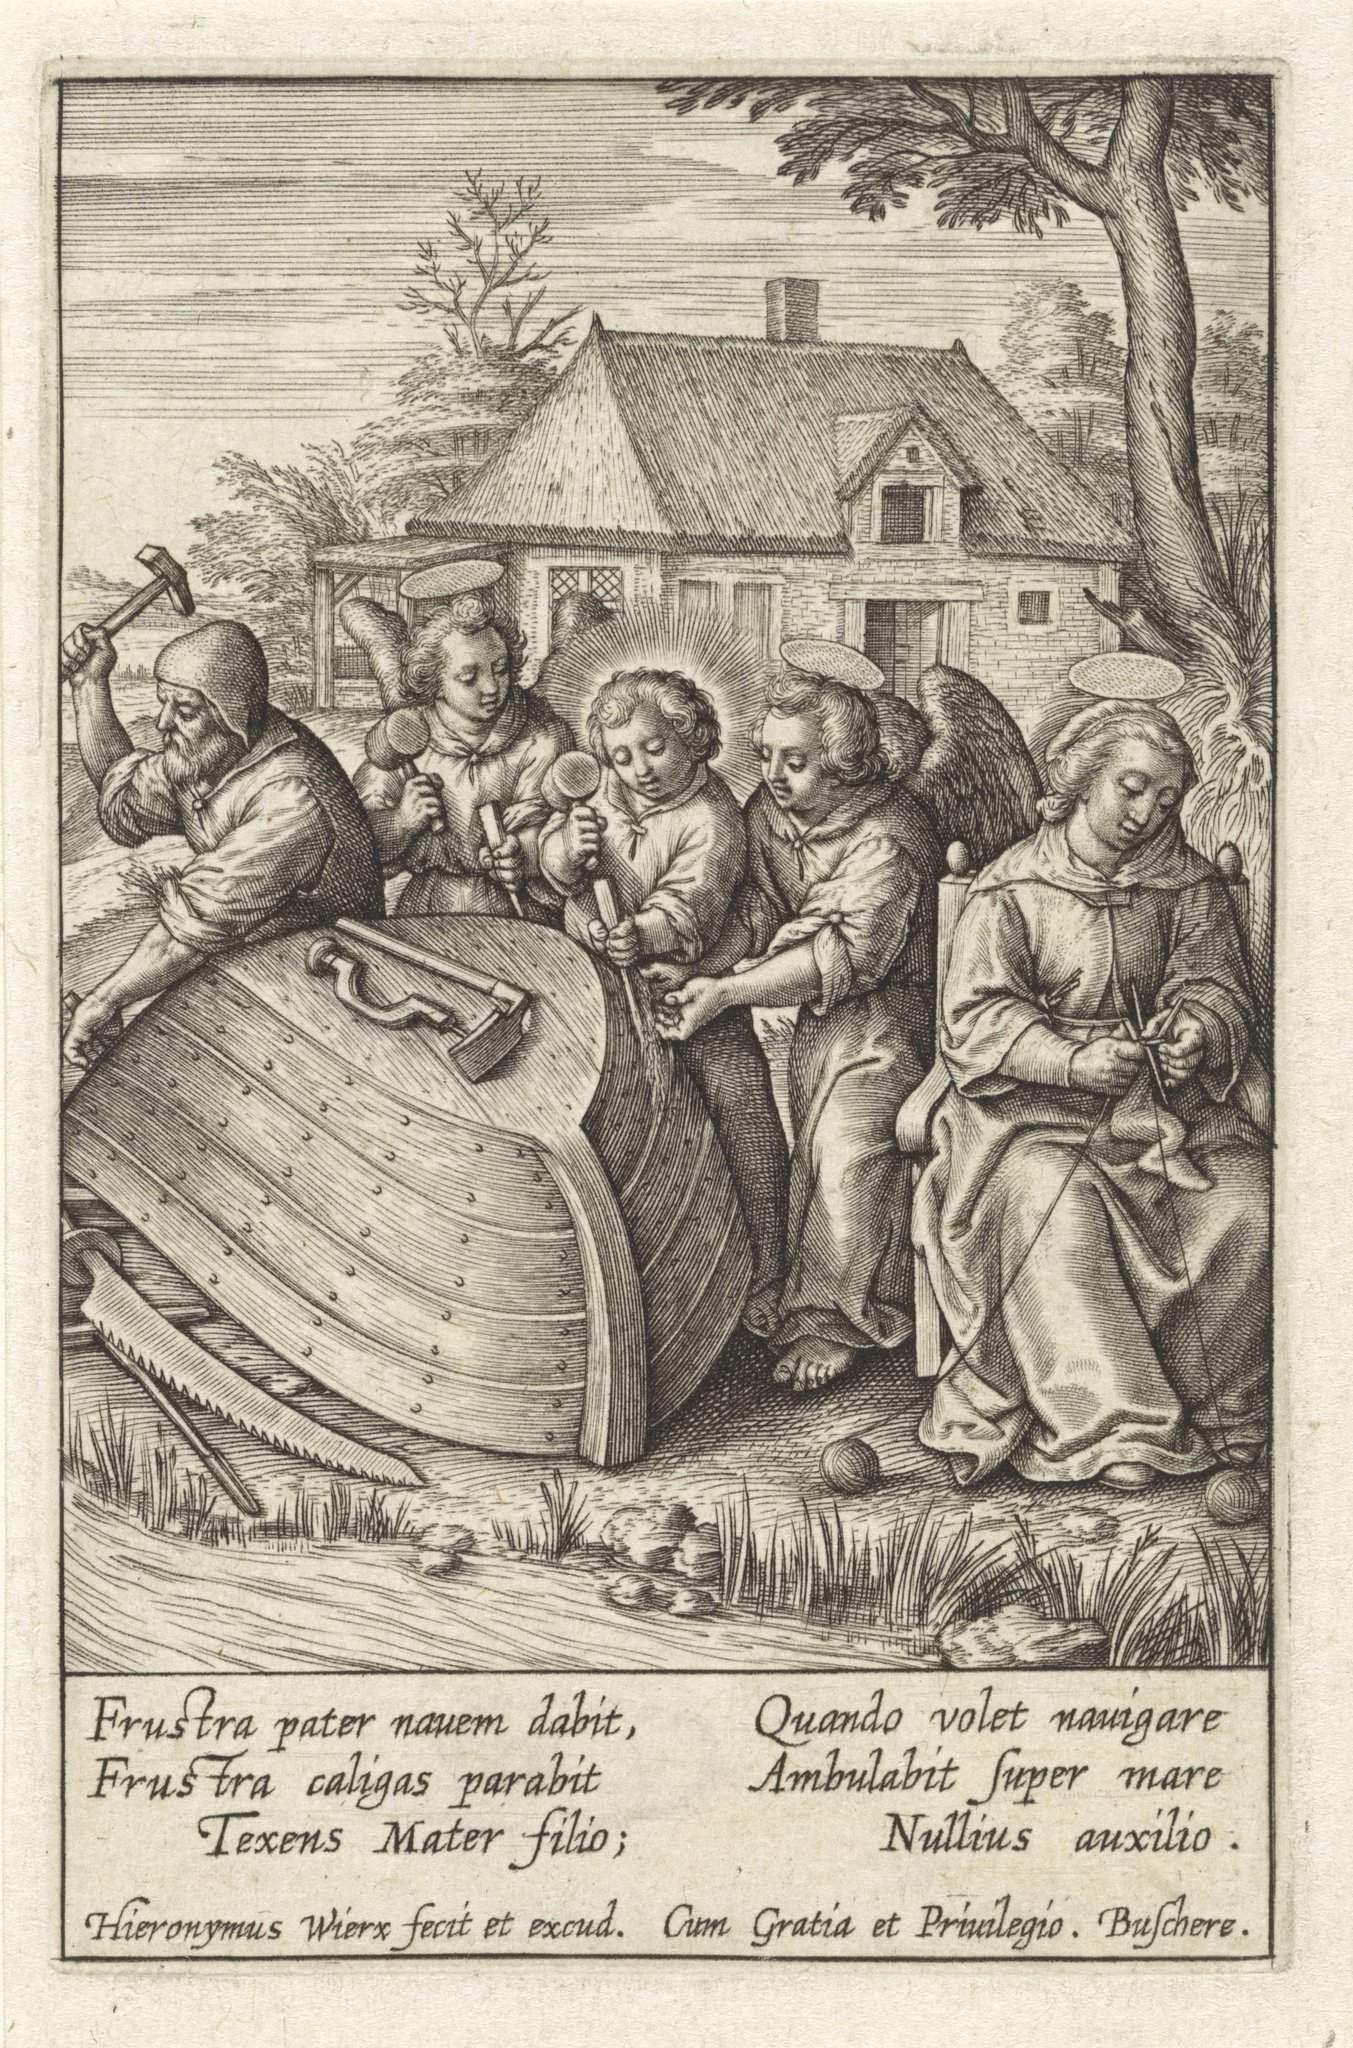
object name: print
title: Iesv Christi dei Domini, salvatoris nri infantia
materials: paper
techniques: engraving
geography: antwerp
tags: joseph and the christ-child ~ daily life in nazareth, household occupations of mary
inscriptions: collector's mark: Lugt 2228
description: Het Christuskind helpt zijn vader Jozef bij het bouwen van een schip. Hij wordt geassisteerd door twee engelen. Maria zit bij hen en is aan het breien. In de marge een zesregelig onderschrift, in twee kolommen, in het Latijn.